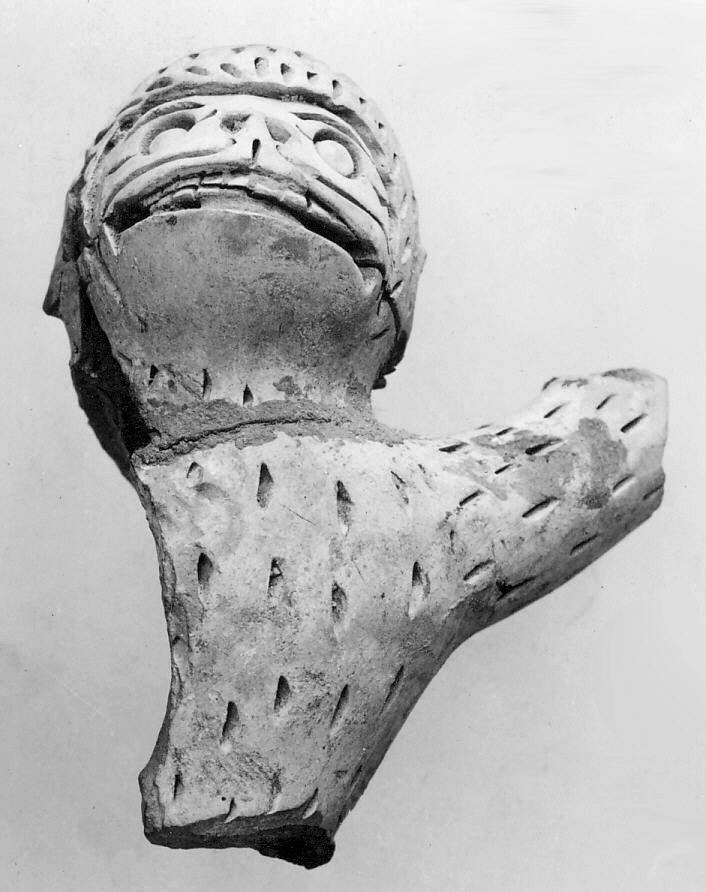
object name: relief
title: Fragment of a Monkey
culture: central asian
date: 1101-1200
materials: terracotta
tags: monkeys